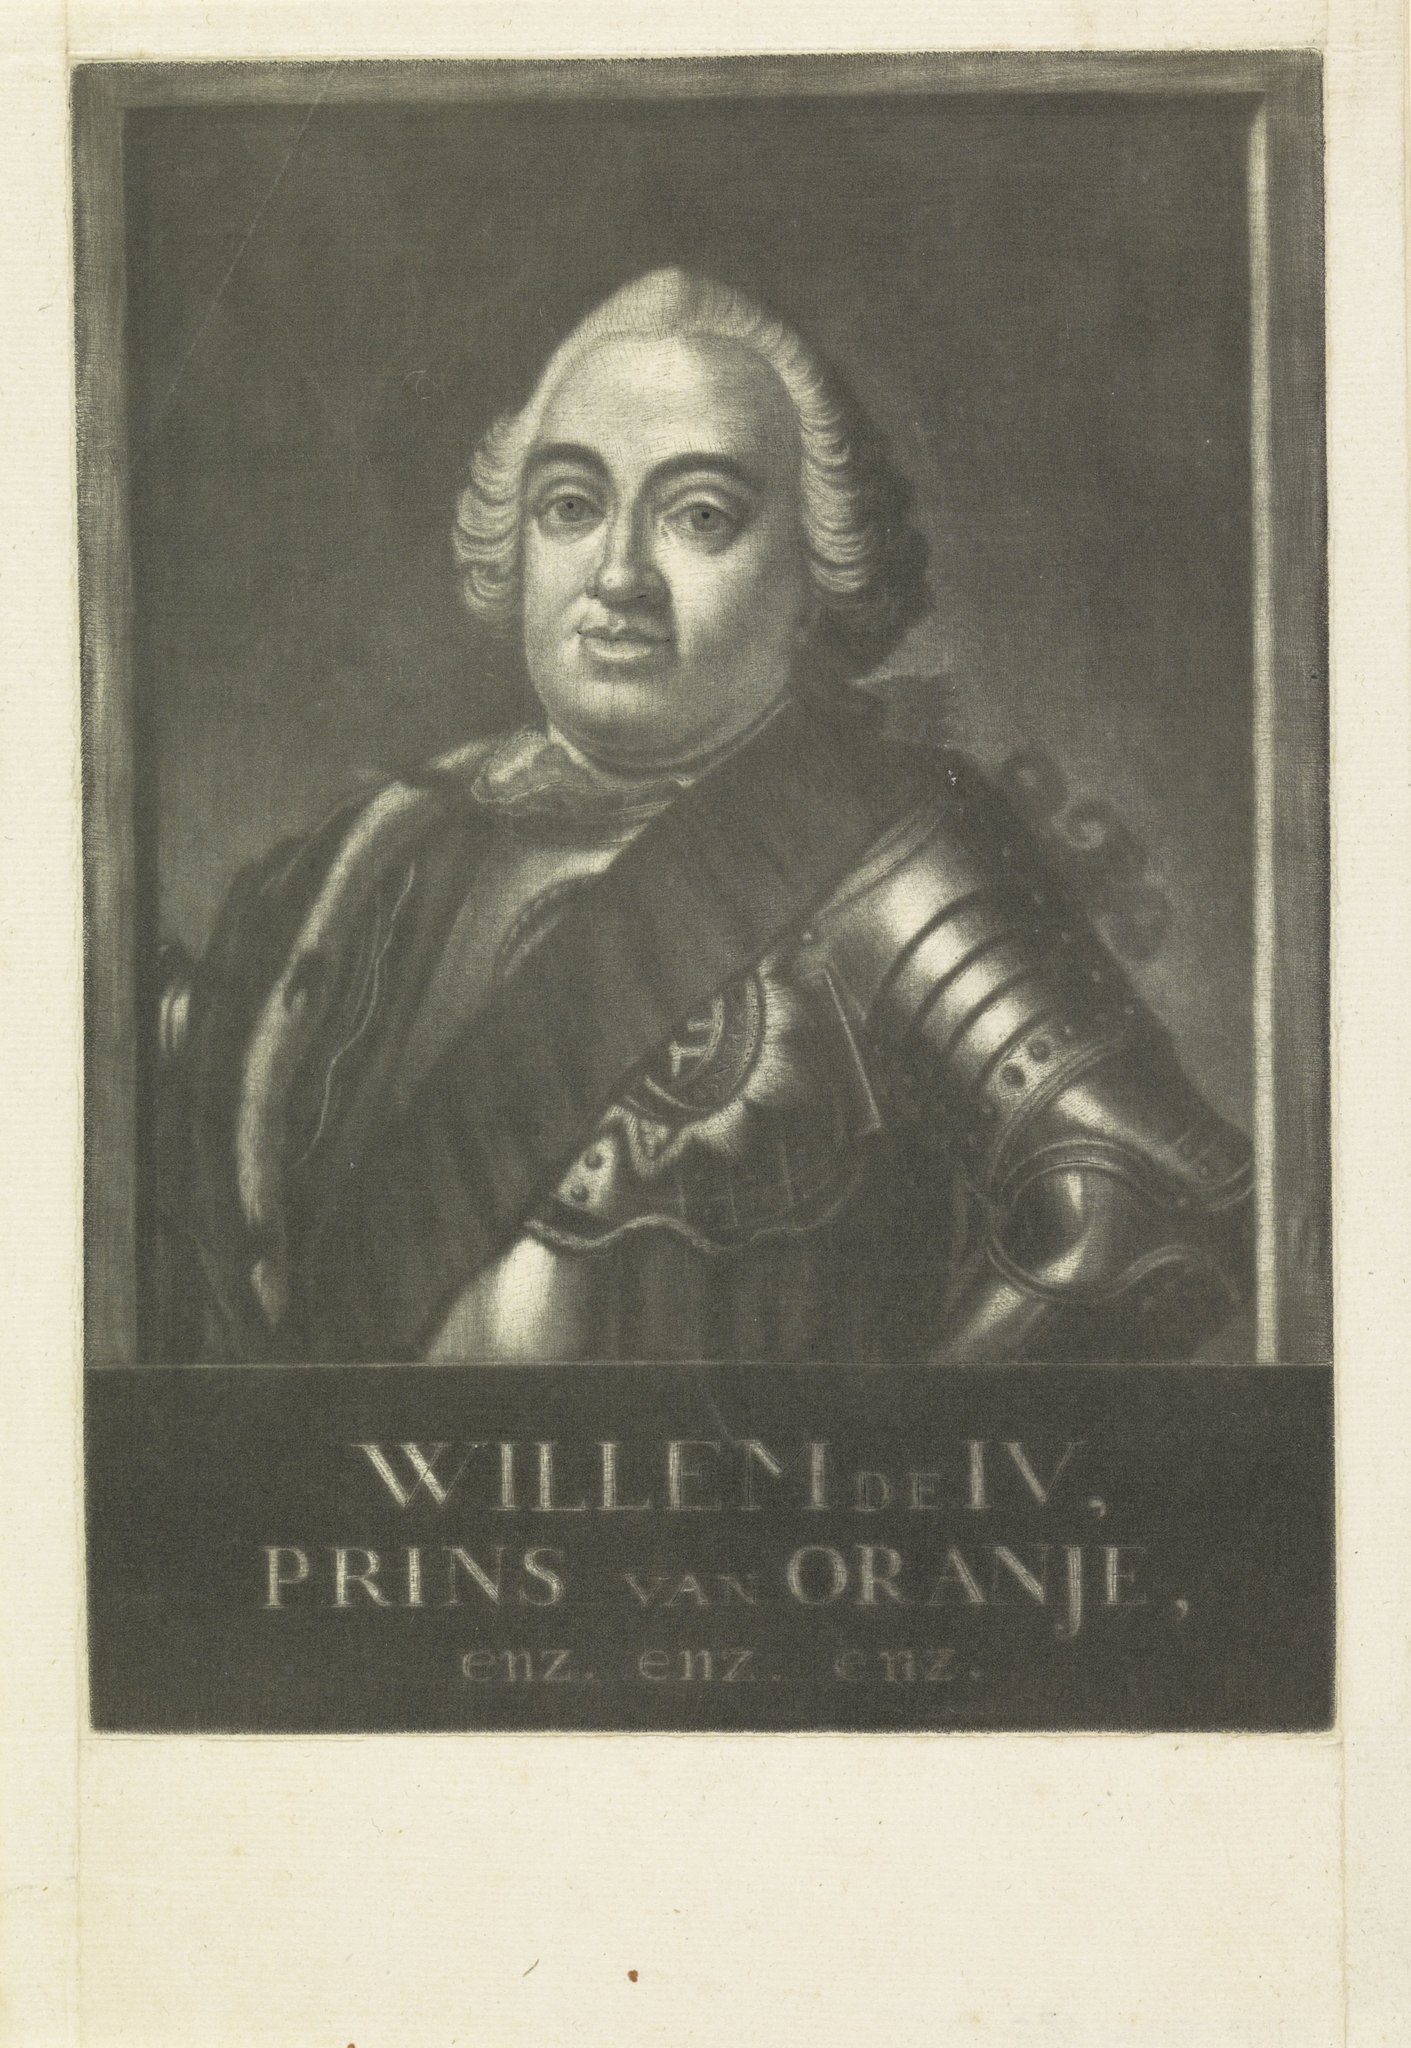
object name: print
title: Portret van Willem IV, prins van Oranje-Nassau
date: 1770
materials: paper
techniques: mezzotint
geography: northern netherlands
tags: the hague, willem iv (prins van oranje-nassau)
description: De hier vermelde titel verwijst naar de hoogst verkregen titel van de geportretteerde, niet per se naar de titel die de geportretteerde op deze voorstelling draagt. Prent uit: Bosch, Johannes van den. De heeren stadhouderen van Vriesland, zedert den jare acht-hondert, volgens hoogst derzelver successie kortelyk beschreven. Leeuwarden: Abraham Ferwerda en Gerrit Tresling, 1770.